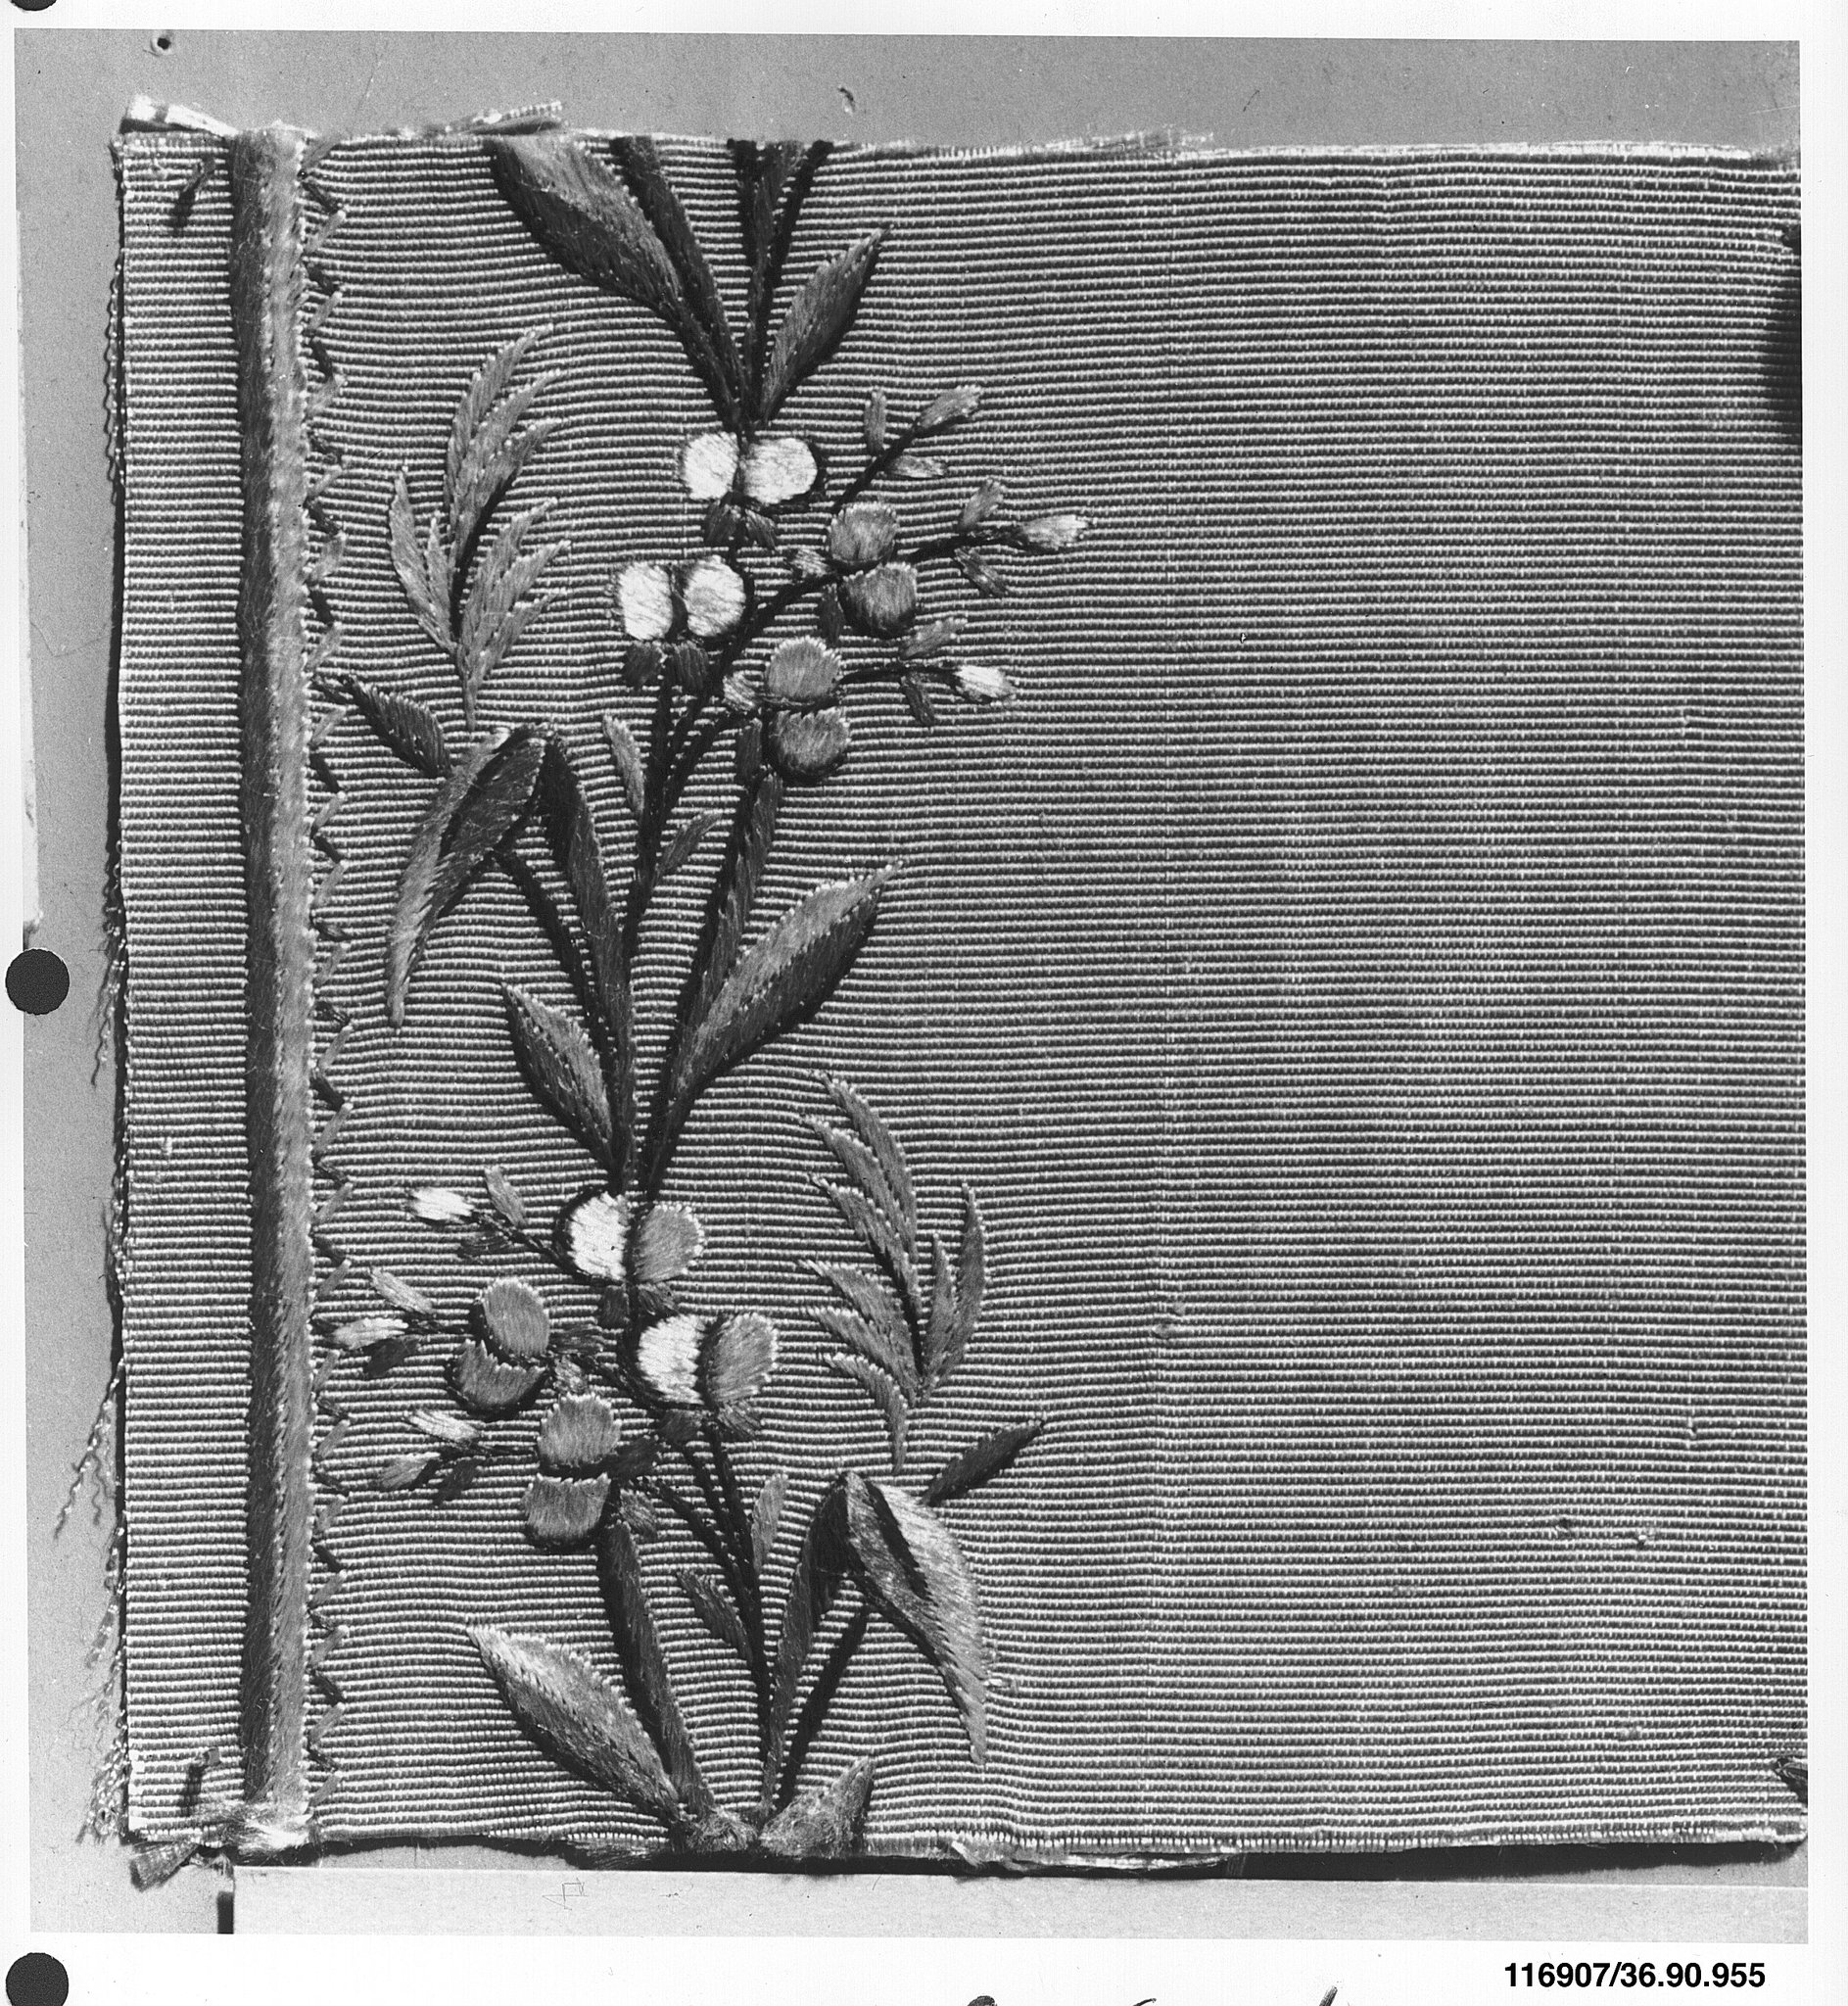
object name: sample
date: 1801-1833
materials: silk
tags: flowers